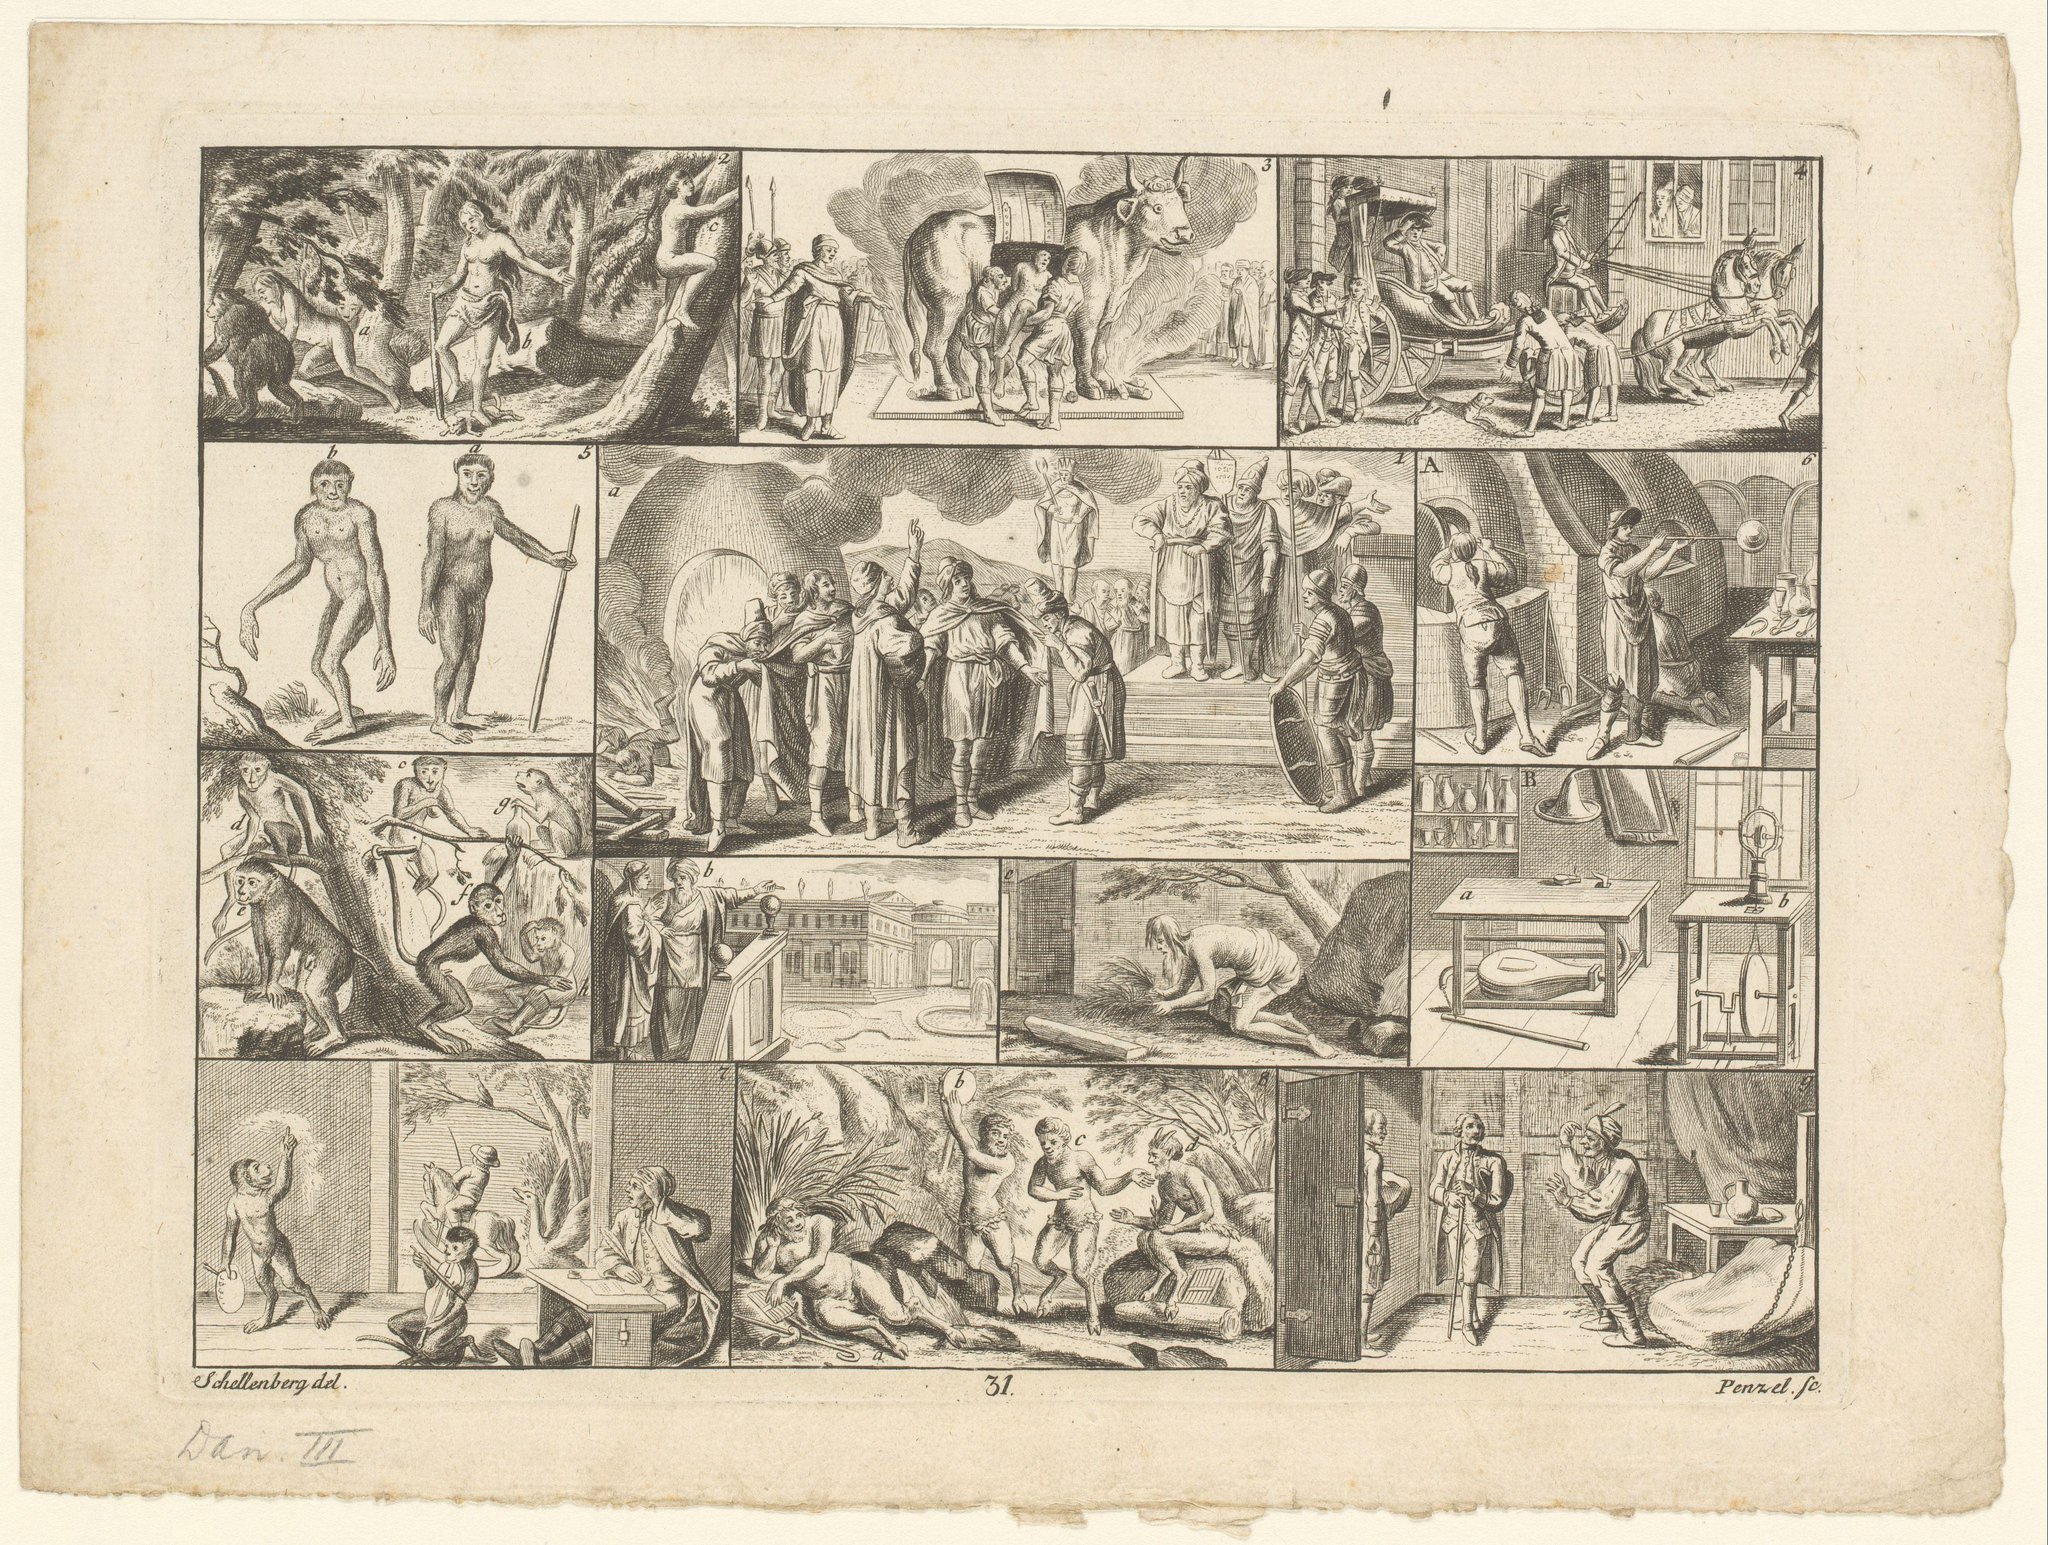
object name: print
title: Blad met uiteenlopende encyclopedische voorstellingen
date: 1784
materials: paper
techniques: engraving, etching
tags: glass-blower, monkeys, apes, after the furnace has been heated seven times more, the three hebrews are bound and thrown into the fire; their executioners are burnt by the flames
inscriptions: collector's mark: Lugt 2228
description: Maakt deel uit van een serie encyclopedische prenten door verschillende kunstenaars naar ontwerp van Daniel Nikolaus Chodowiecki bij Johann Sigmund Stoy's 'Bilder-Akademie für die Jugend', uitgegeven te Neurenberg in 1784. De prenten waren bedoeld voor kinderen om uit te knippen, op kaarten te plakken en vervolgens op logische wijze te rangschikken (zie Heesen, Anke te. The World in a Box: The Story of an Eighteenth-Century Picture Encyclopedia. Chicago: University of Chicago Press, 2002).